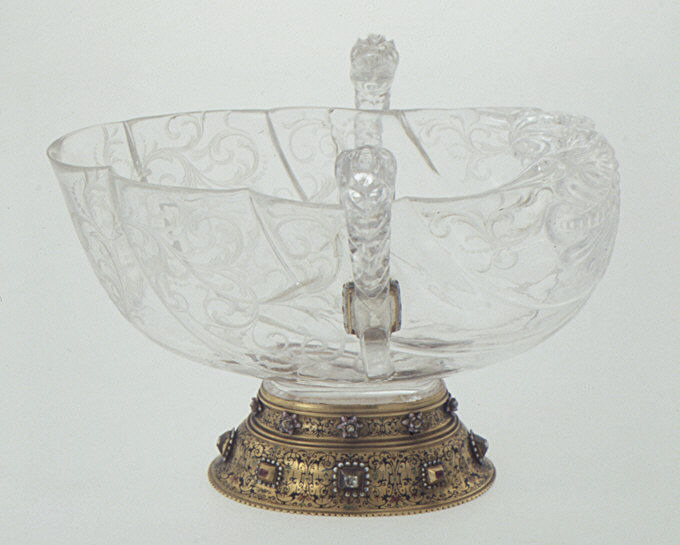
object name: cup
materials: quartz, silver gilt